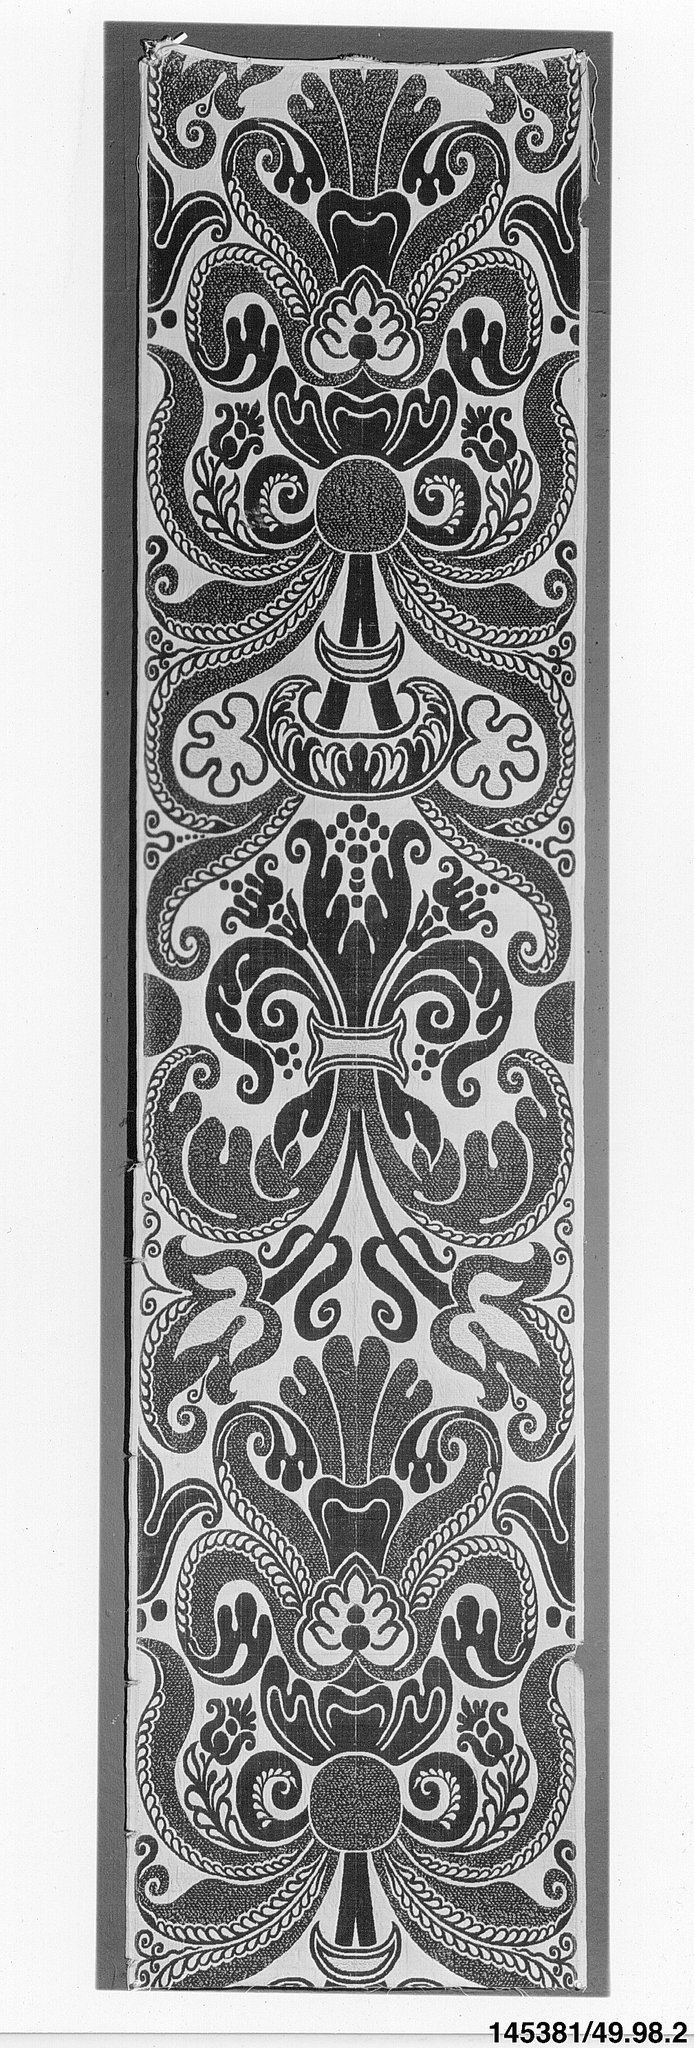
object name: piece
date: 1601-1700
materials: metal thread, silk